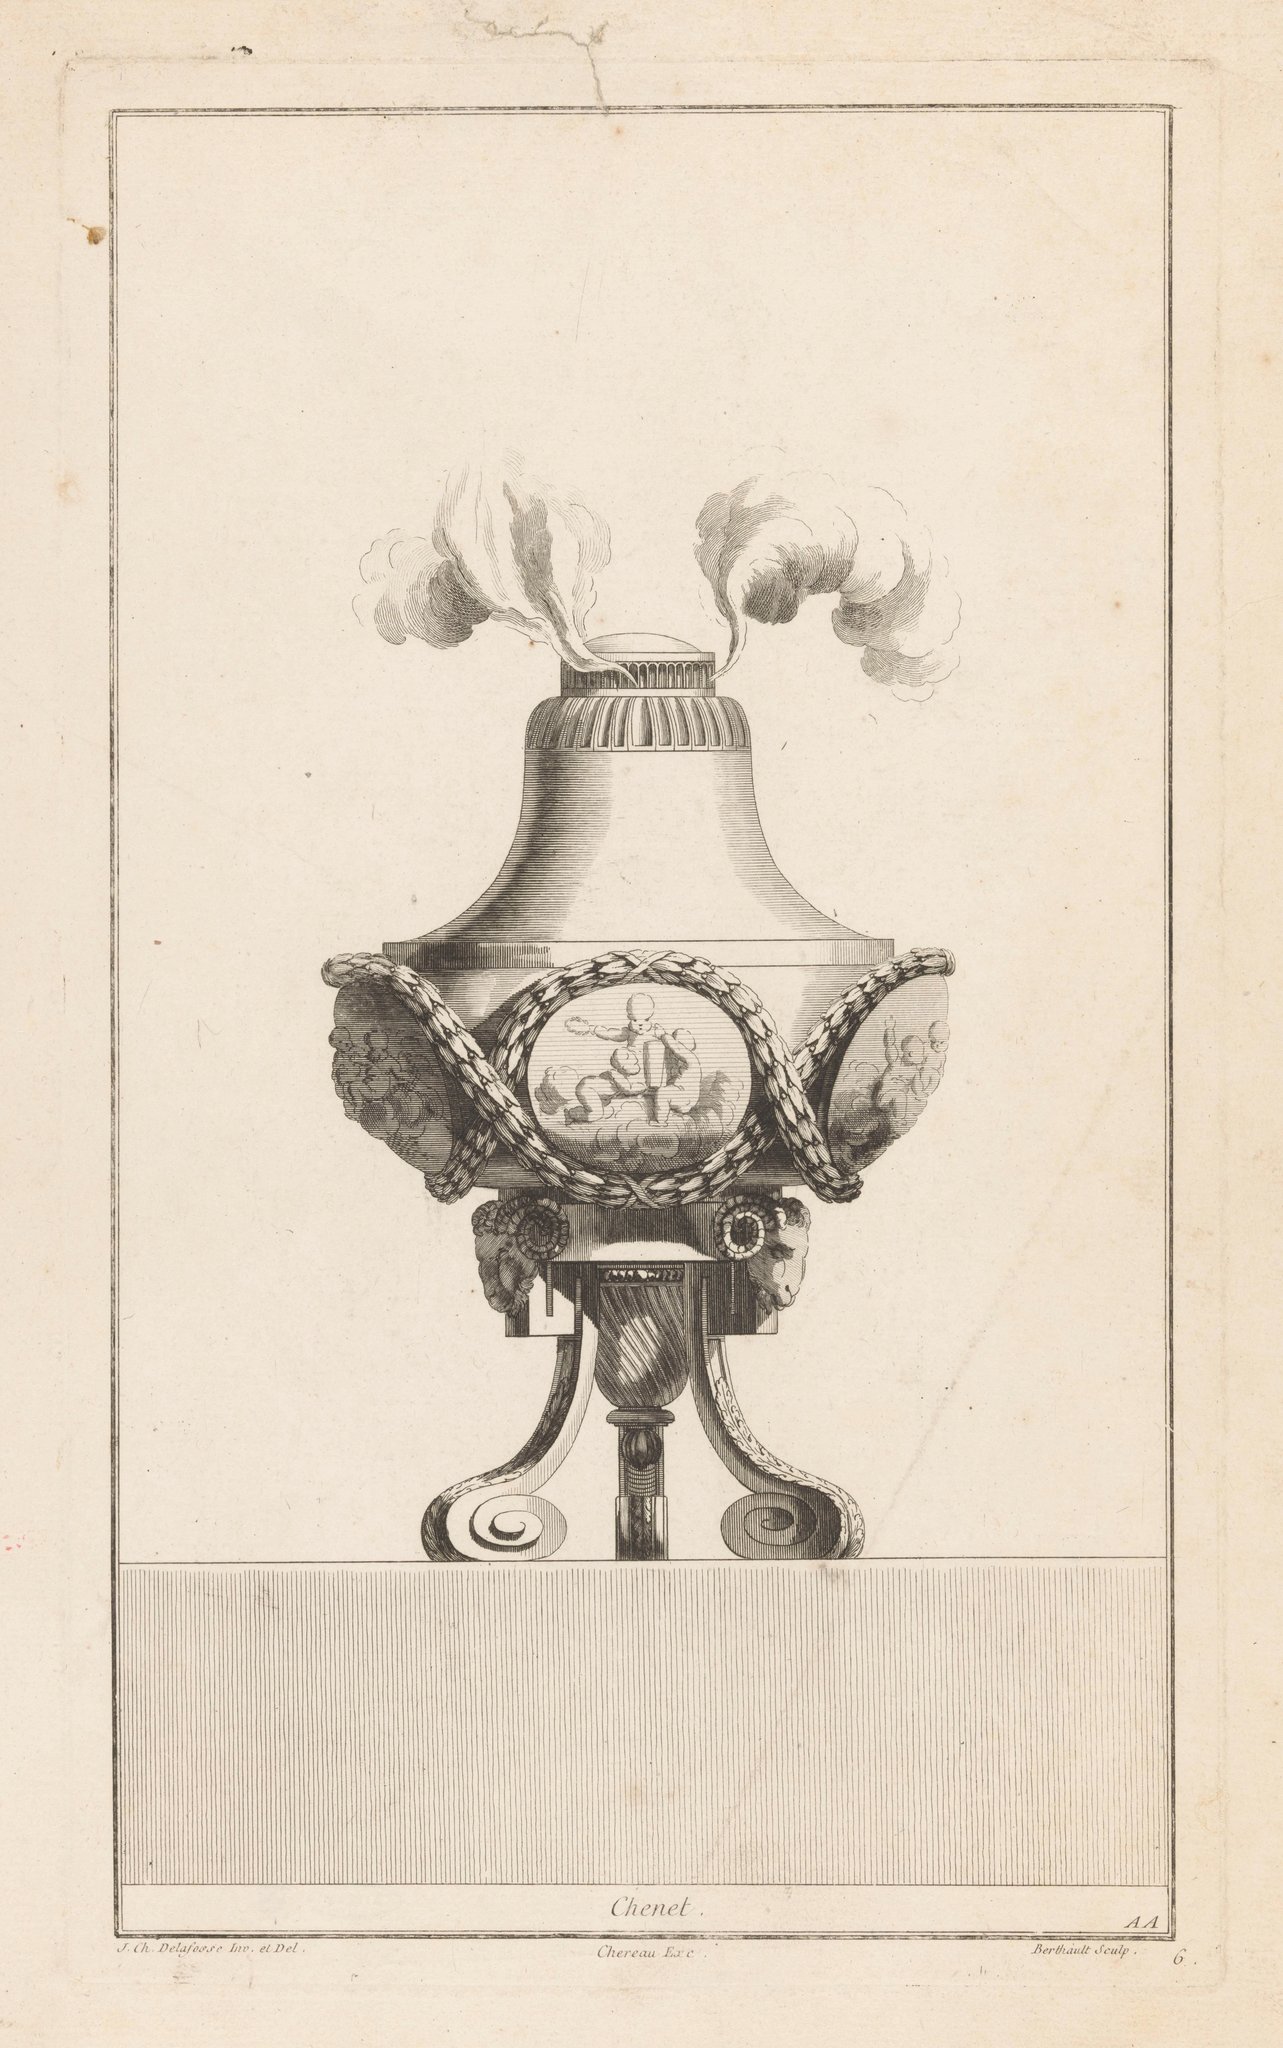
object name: ornament print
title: 25e Cahier AA Cayer de 6 Grilles de Chenets et de Feux de Cheminées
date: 1771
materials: paper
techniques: engraving, etching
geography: paris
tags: andiron, fire-dog, incense-burner ~ scents, perfumes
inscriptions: collector's mark: Lugt 2228, collector's mark: Lugt 2760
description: Een geornamenteerde vuurbok in de vorm van een rookvat met medaillons met putti en ramskoppen.